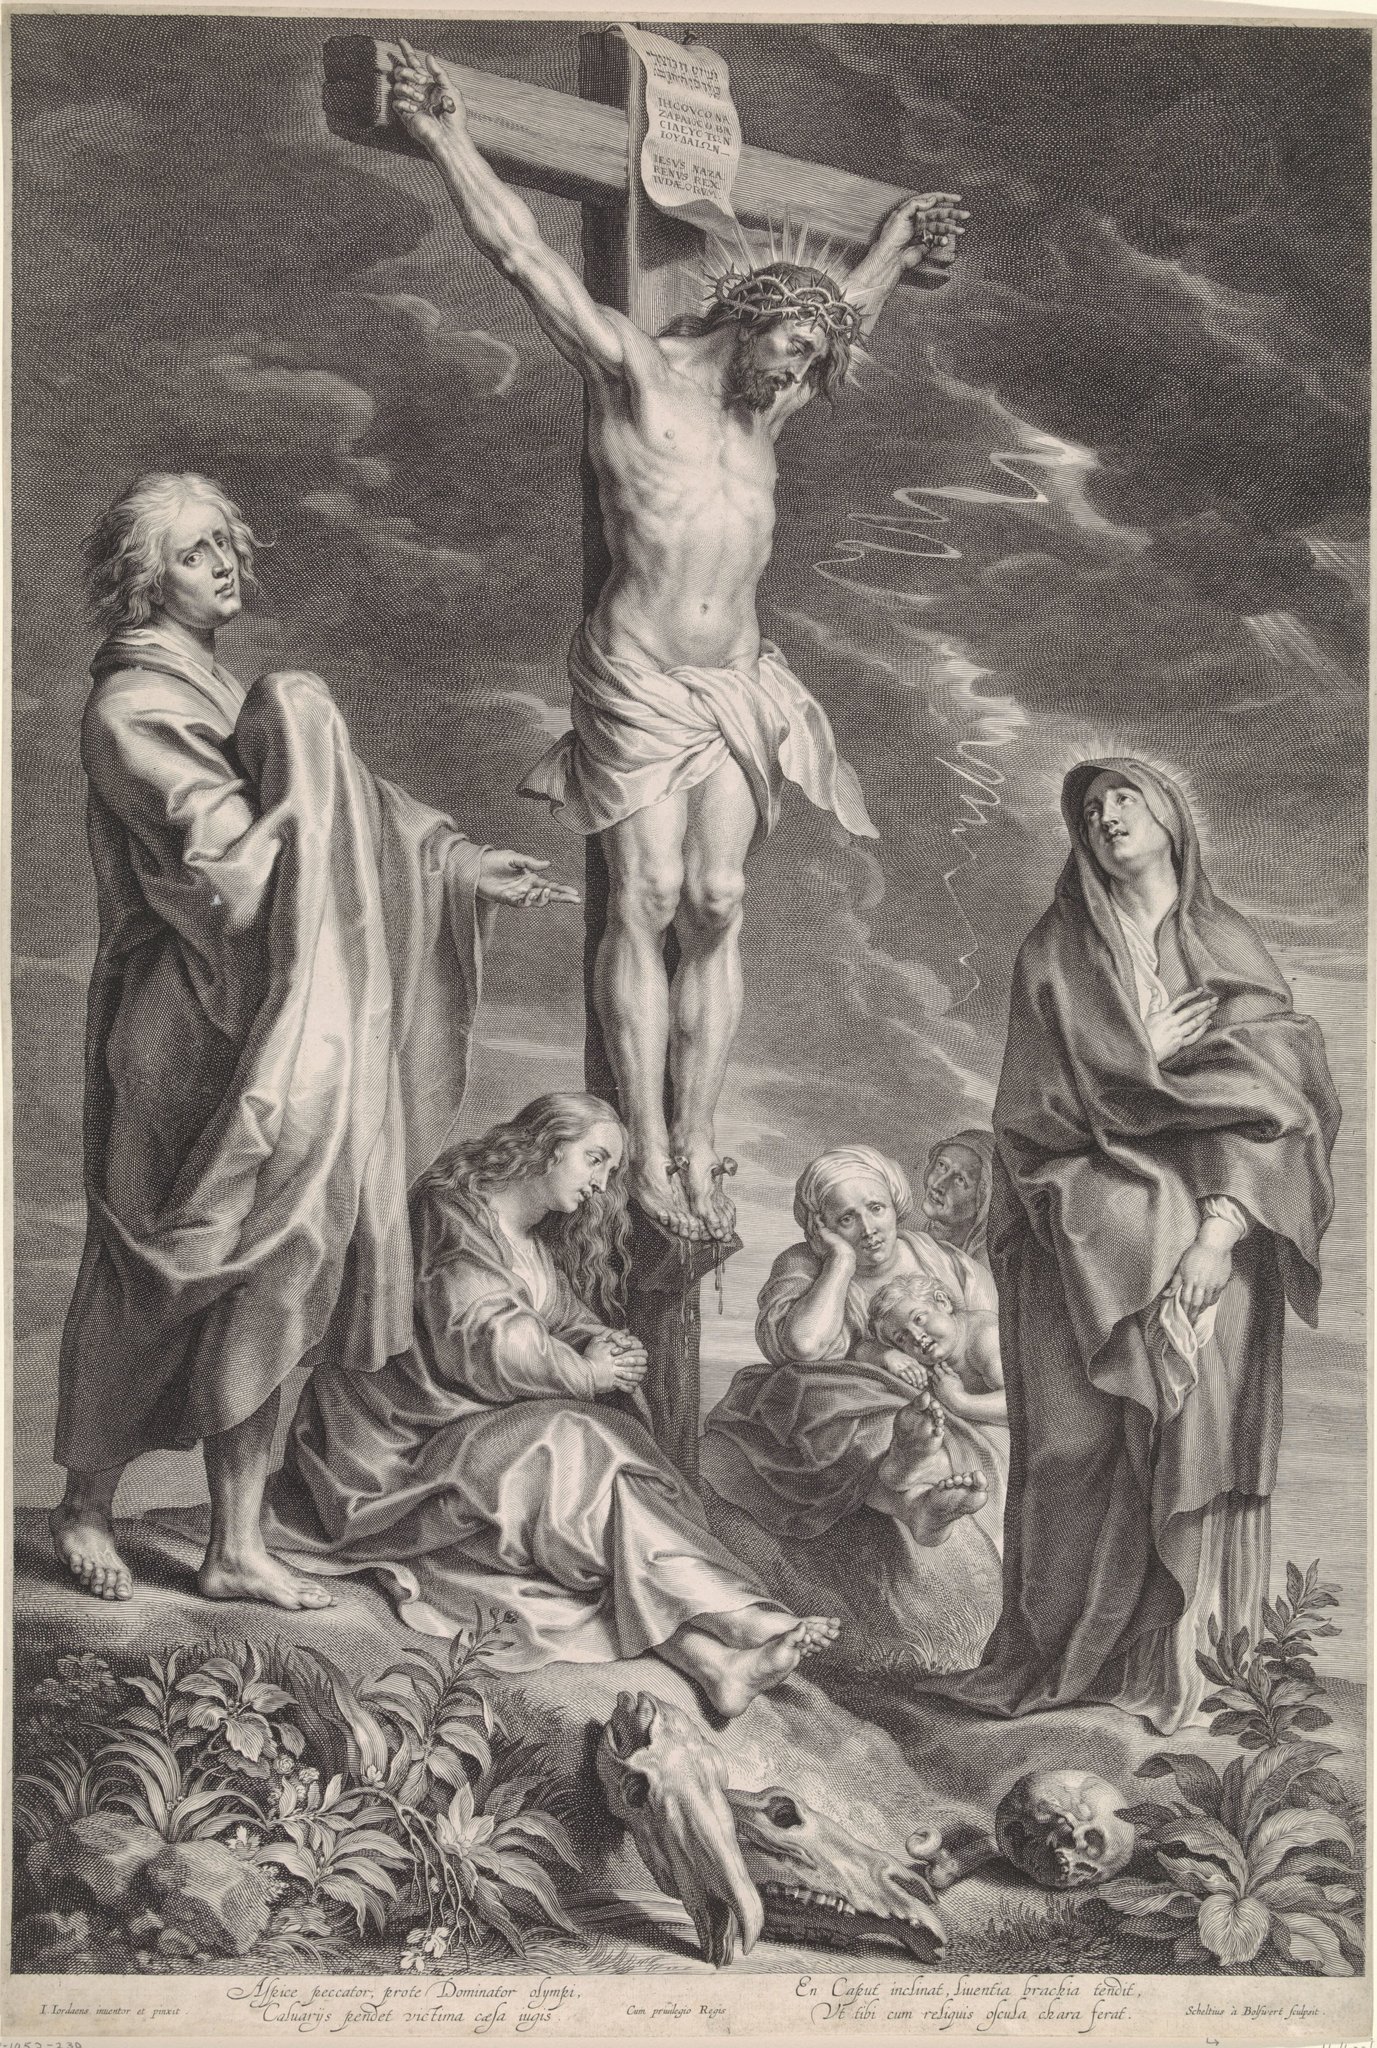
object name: print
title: Christus aan het kruis, met Maria en Johannes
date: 1596-1659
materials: paper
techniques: engraving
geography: netherlands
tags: crucified christ with mary, john, and mary magdalene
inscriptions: collector's mark: Lugt 2228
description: Christus aan het kruis, met Maria en Johannes staand onder het kruis en Maria Magdalena zittend aan de voet van het kruis bij de genagelde voeten van Christus. In de marge onder staat een Latijns vers in vier regels.